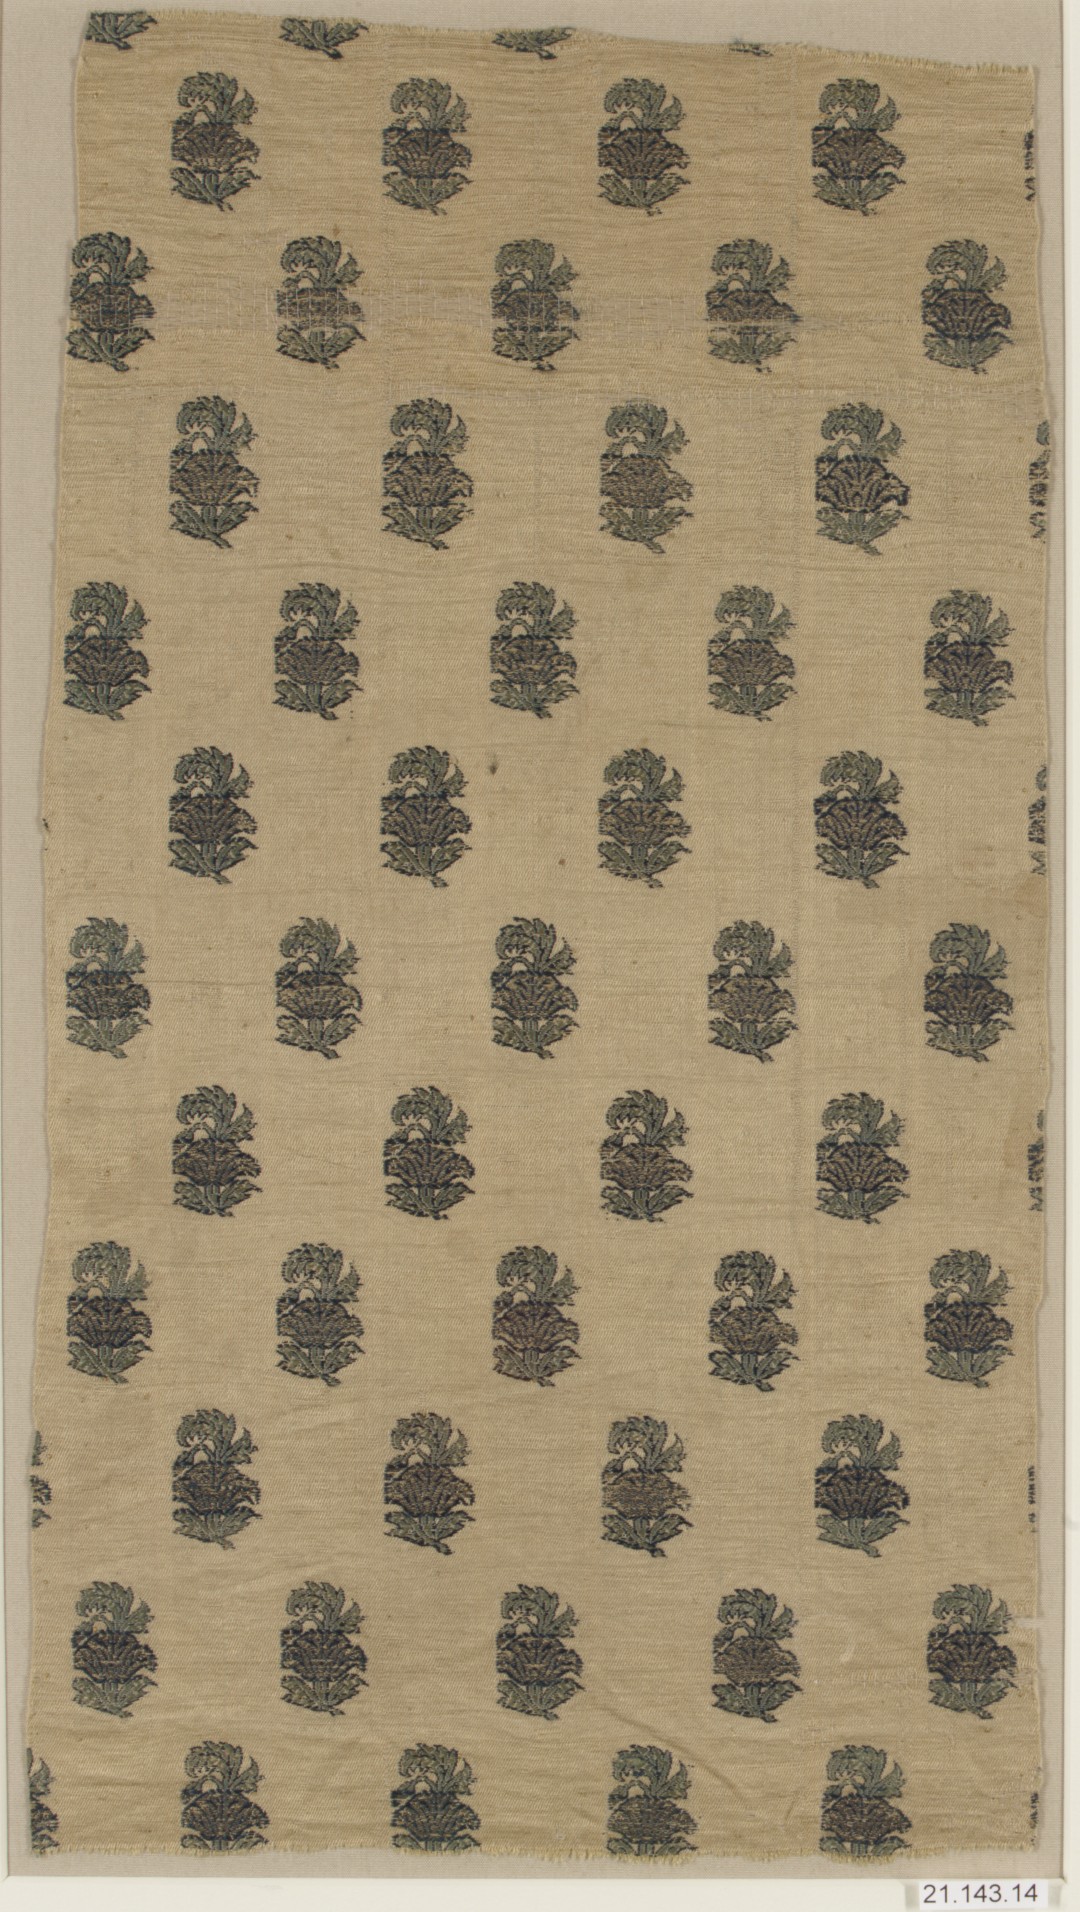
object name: brocade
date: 1701-1800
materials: cotton, metal thread, silk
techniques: brocade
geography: india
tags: flowers